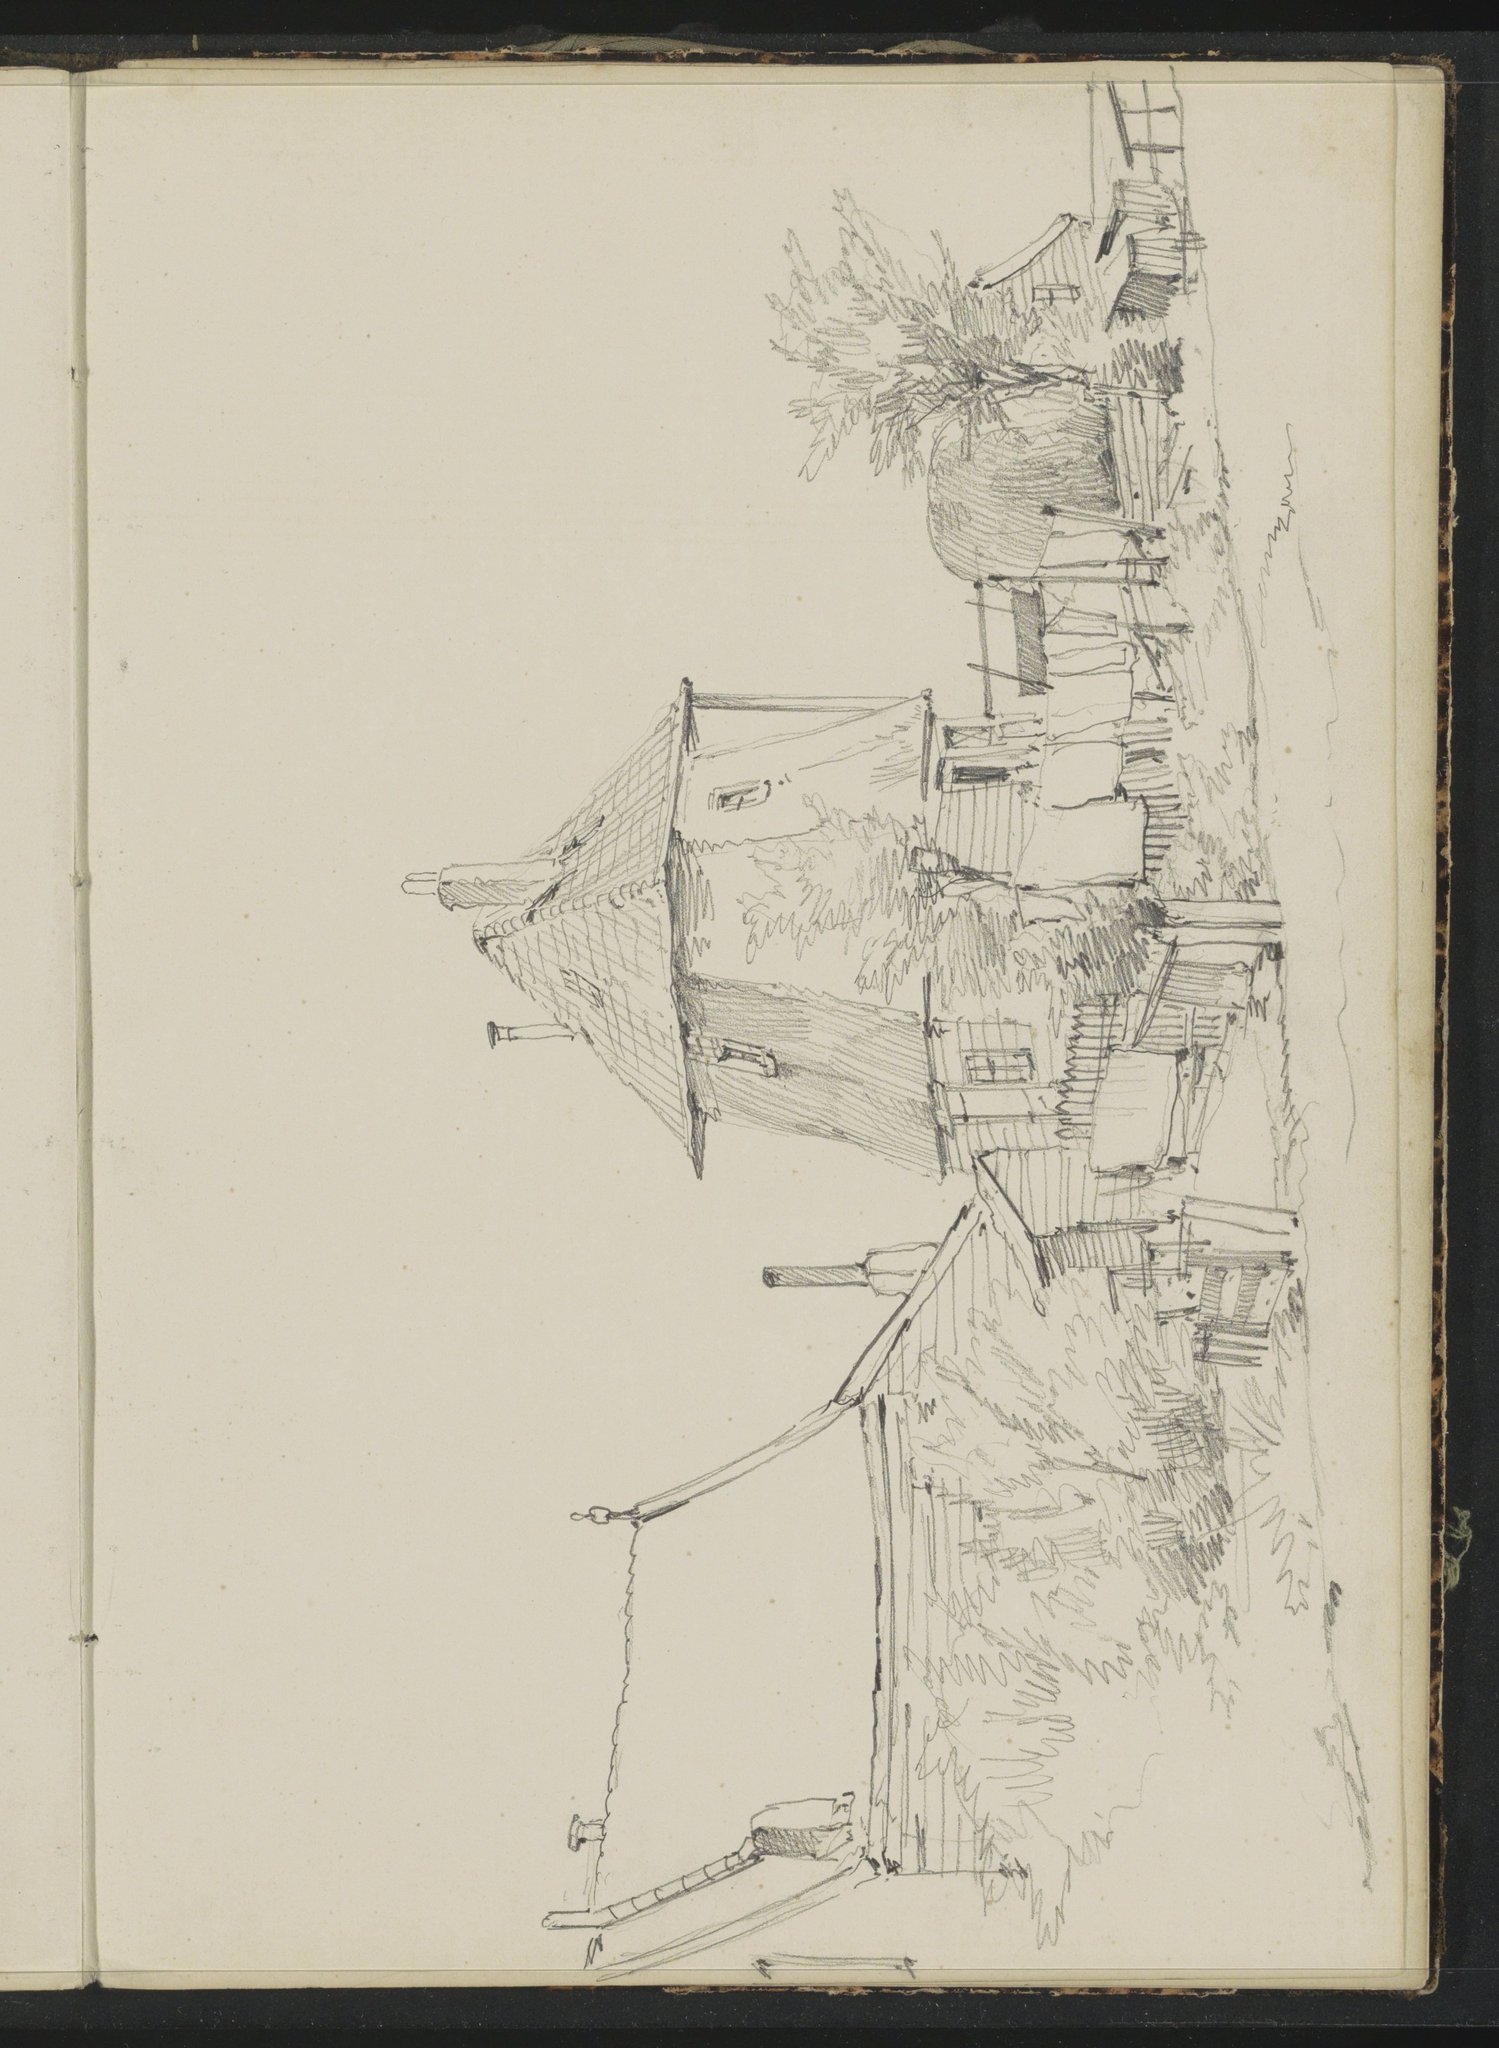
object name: sketchbook leaf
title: Boerenwoningen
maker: willem koekkoek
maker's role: draughtsman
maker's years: 1839-1895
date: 1888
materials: paper, pencil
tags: cottage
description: Blad 16 recto uit een schetsboek met 24 bladen.